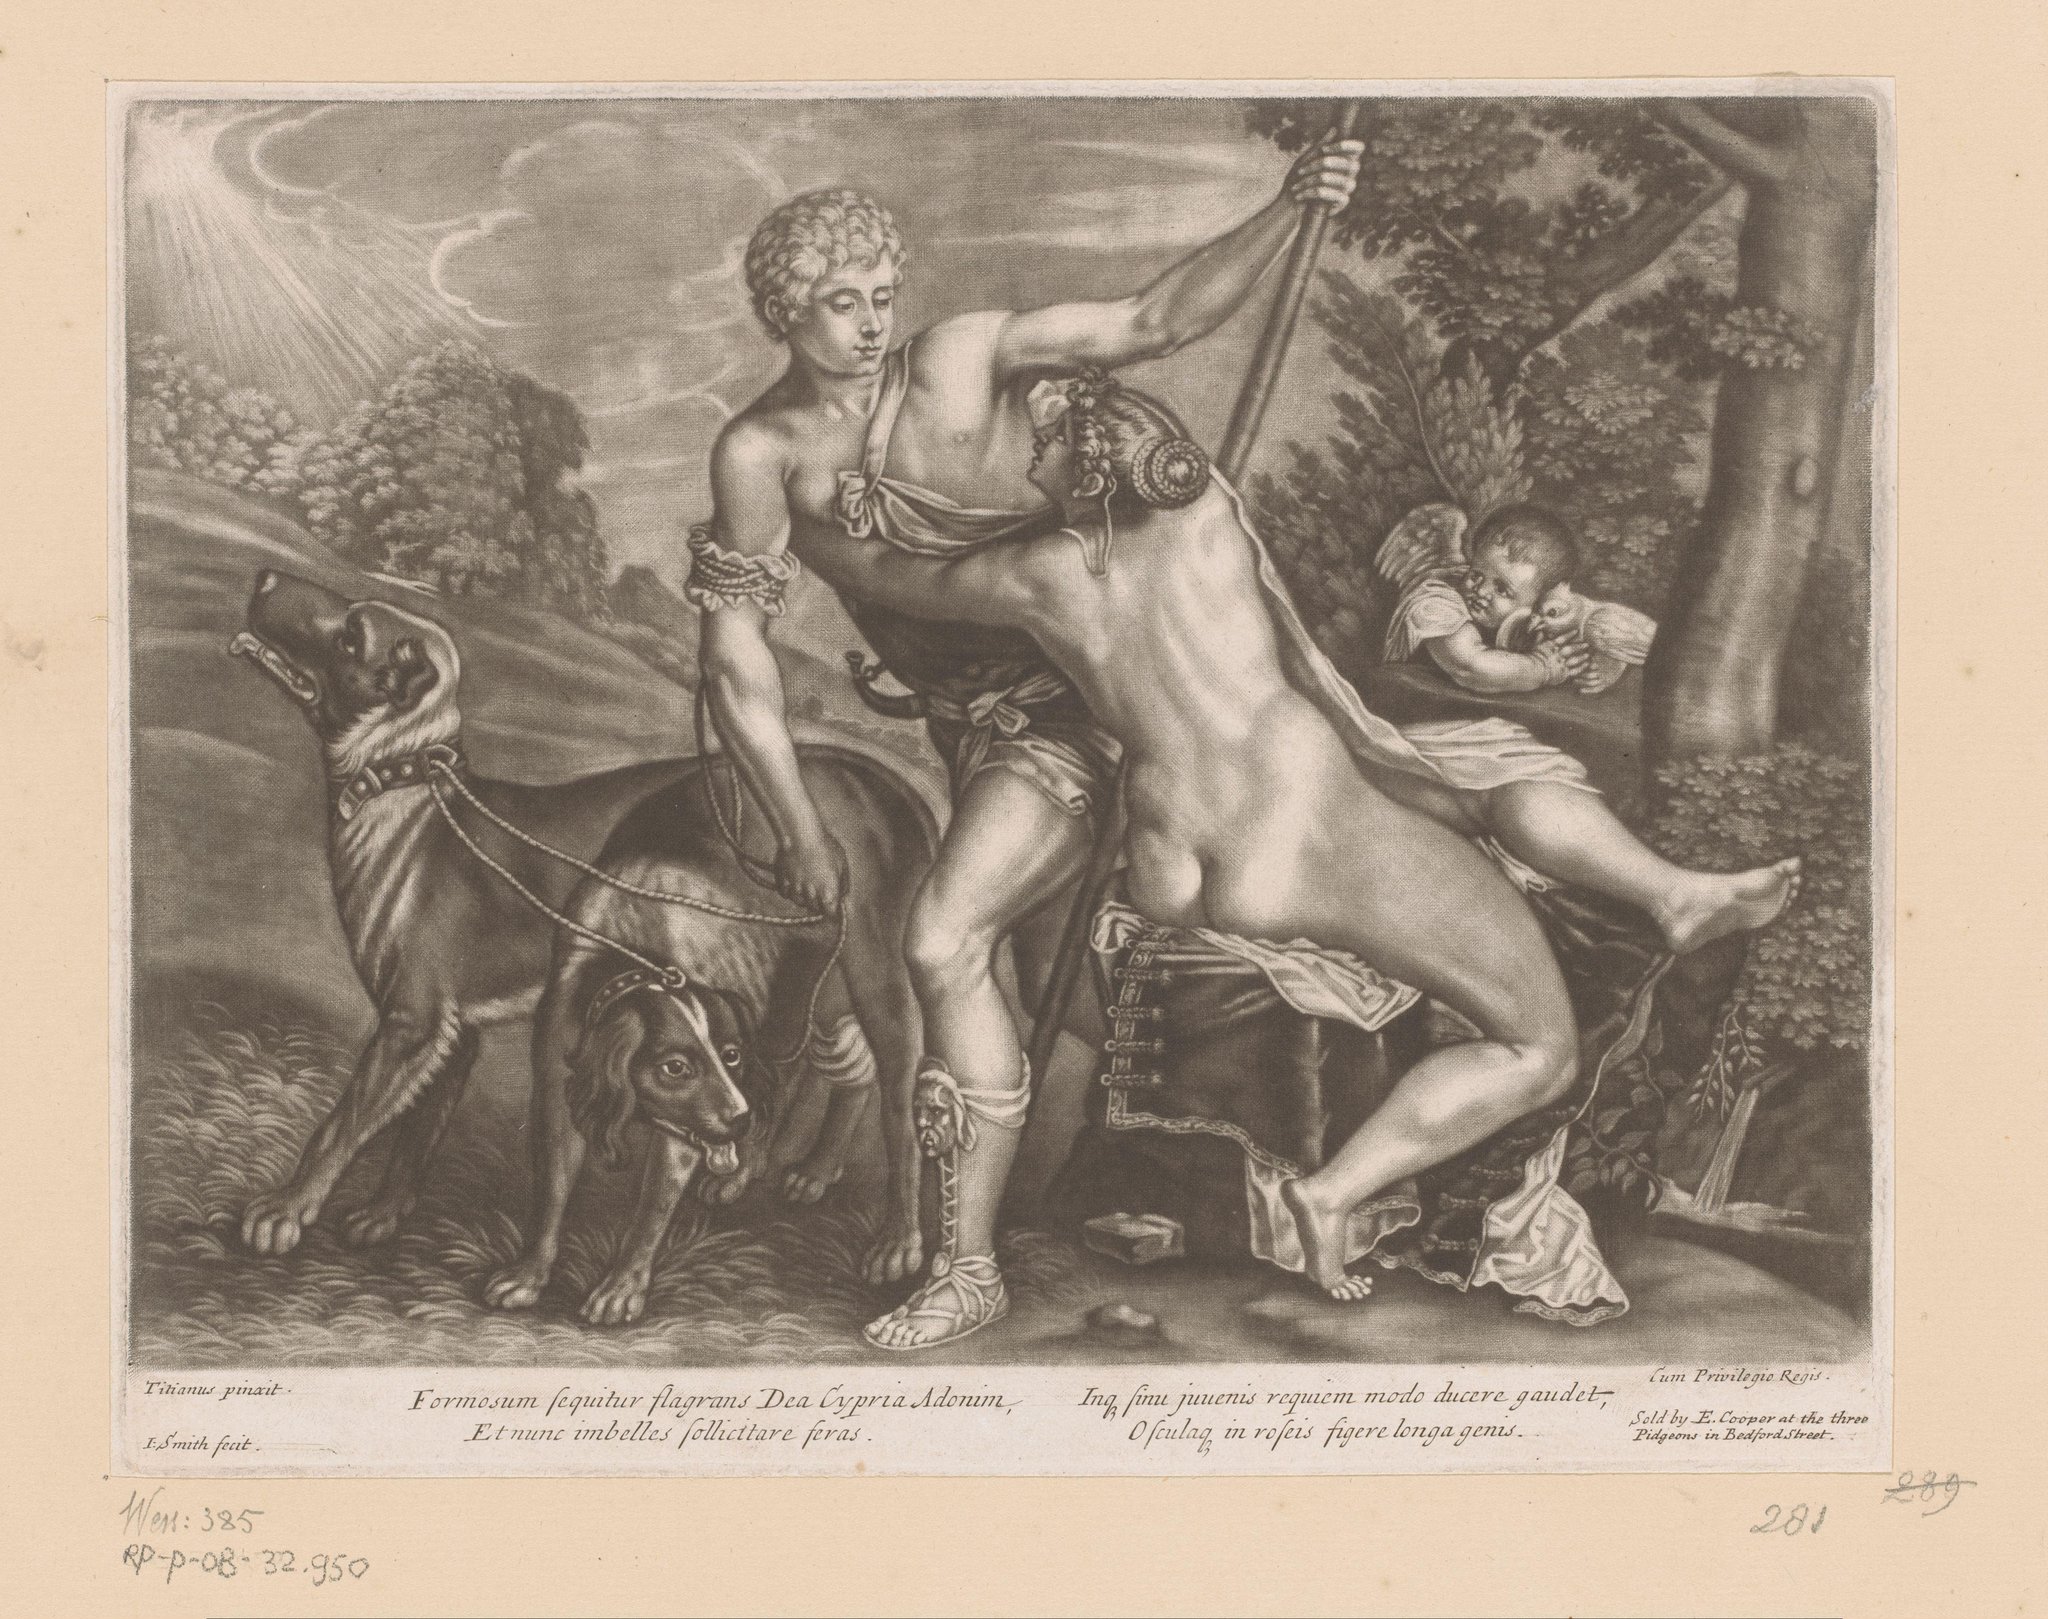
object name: print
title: Venus and Adonis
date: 1686-1725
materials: paper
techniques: mezzotint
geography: london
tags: venus trying to prevent adonis from going hunting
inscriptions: collector's mark: Lugt 240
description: Tekst in het Latijn in de ondermarge. Jachthonden en een cupido met een duif om hen heen.